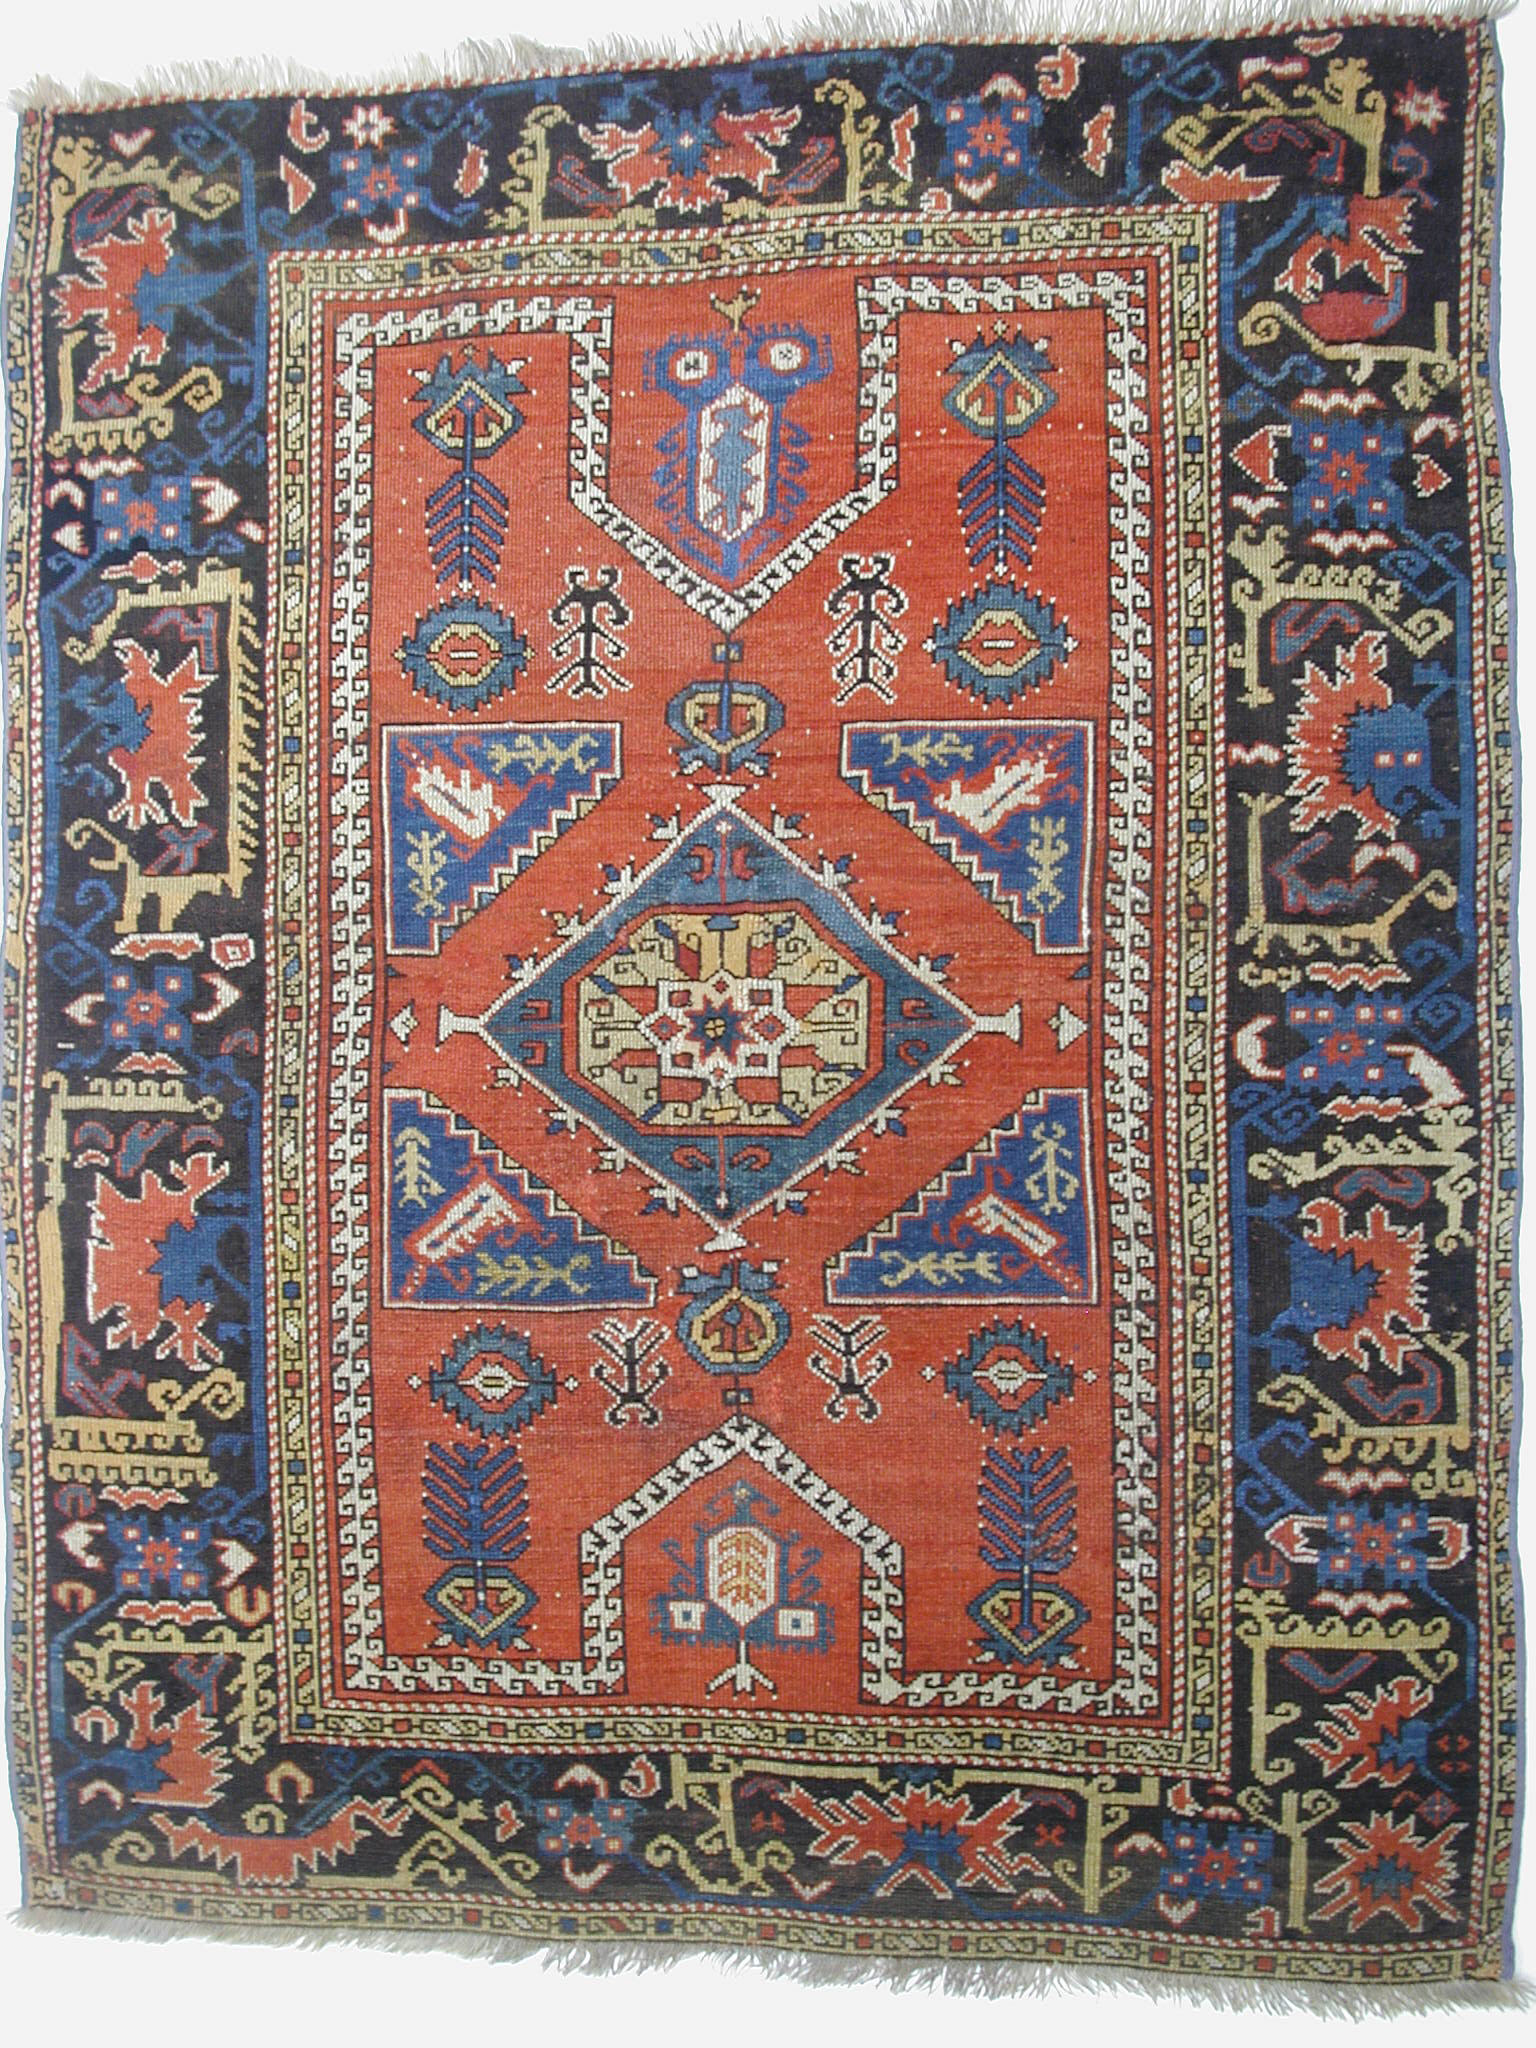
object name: carpet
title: Double-Ended Bellini Carpet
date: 1767-1800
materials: wool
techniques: pile